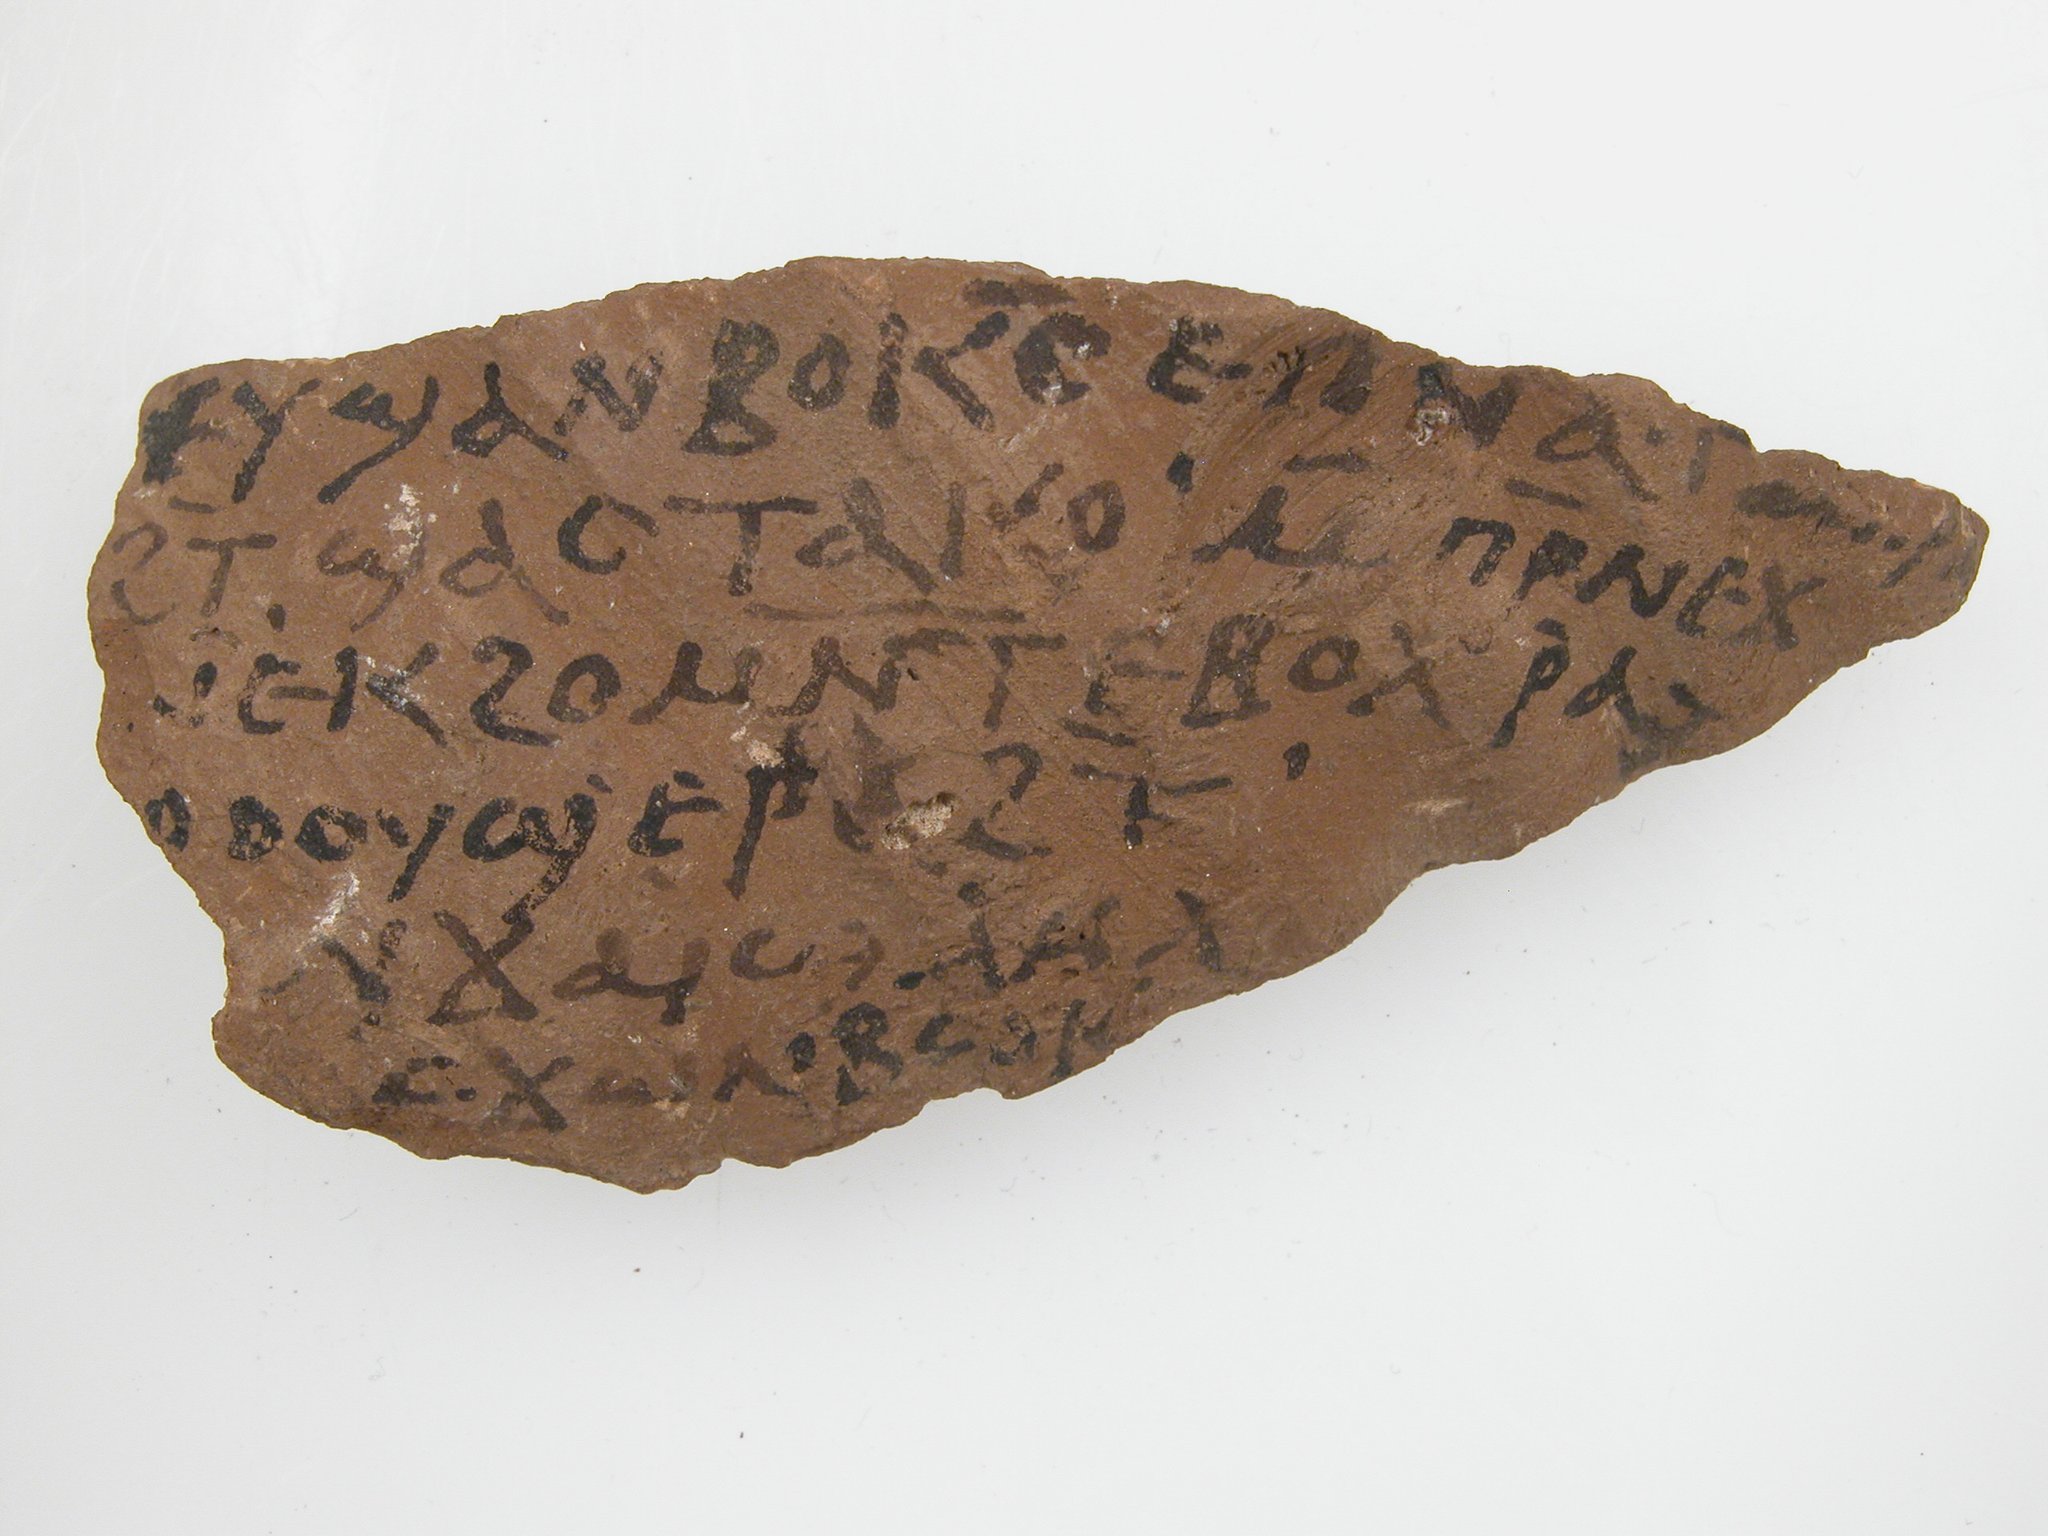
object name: ostrakon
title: Ostrakon with a Letter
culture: coptic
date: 580-640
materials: ink, pottery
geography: egypt